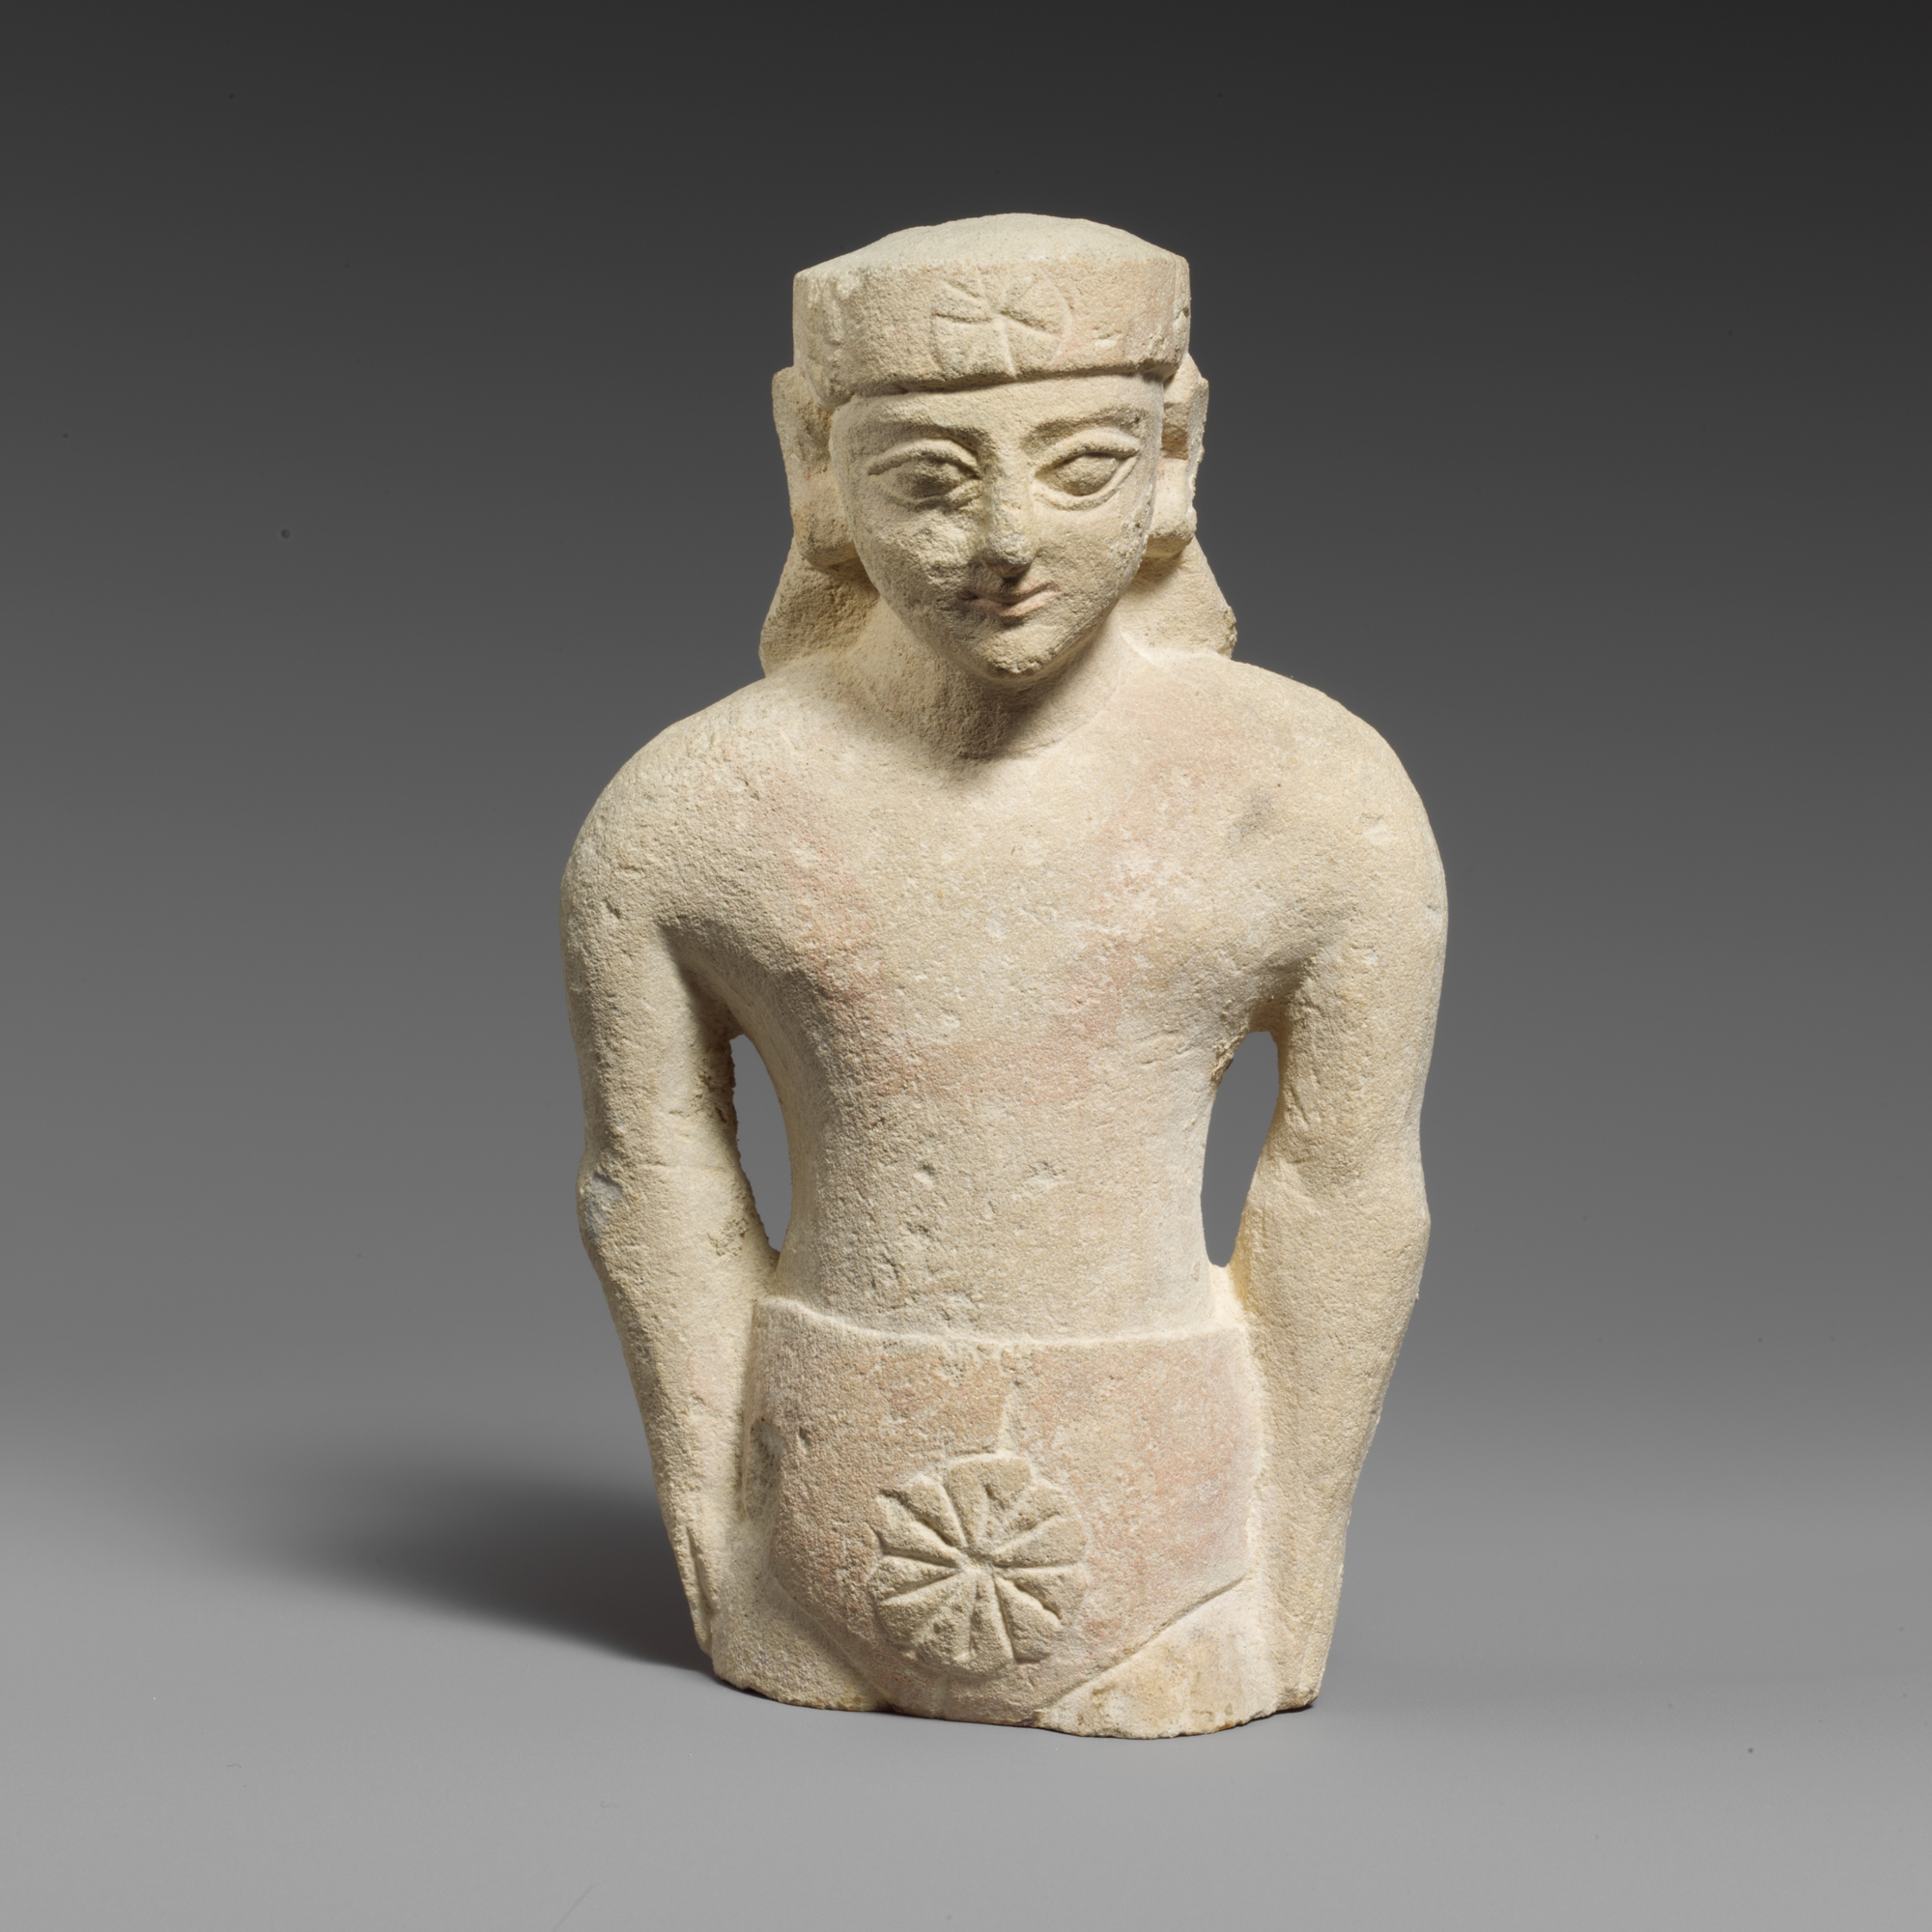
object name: statuette of a votary, male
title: Limestone statuette of a male votary with Cypriot shorts and a diadem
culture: cypriot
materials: limestone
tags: diadems,men